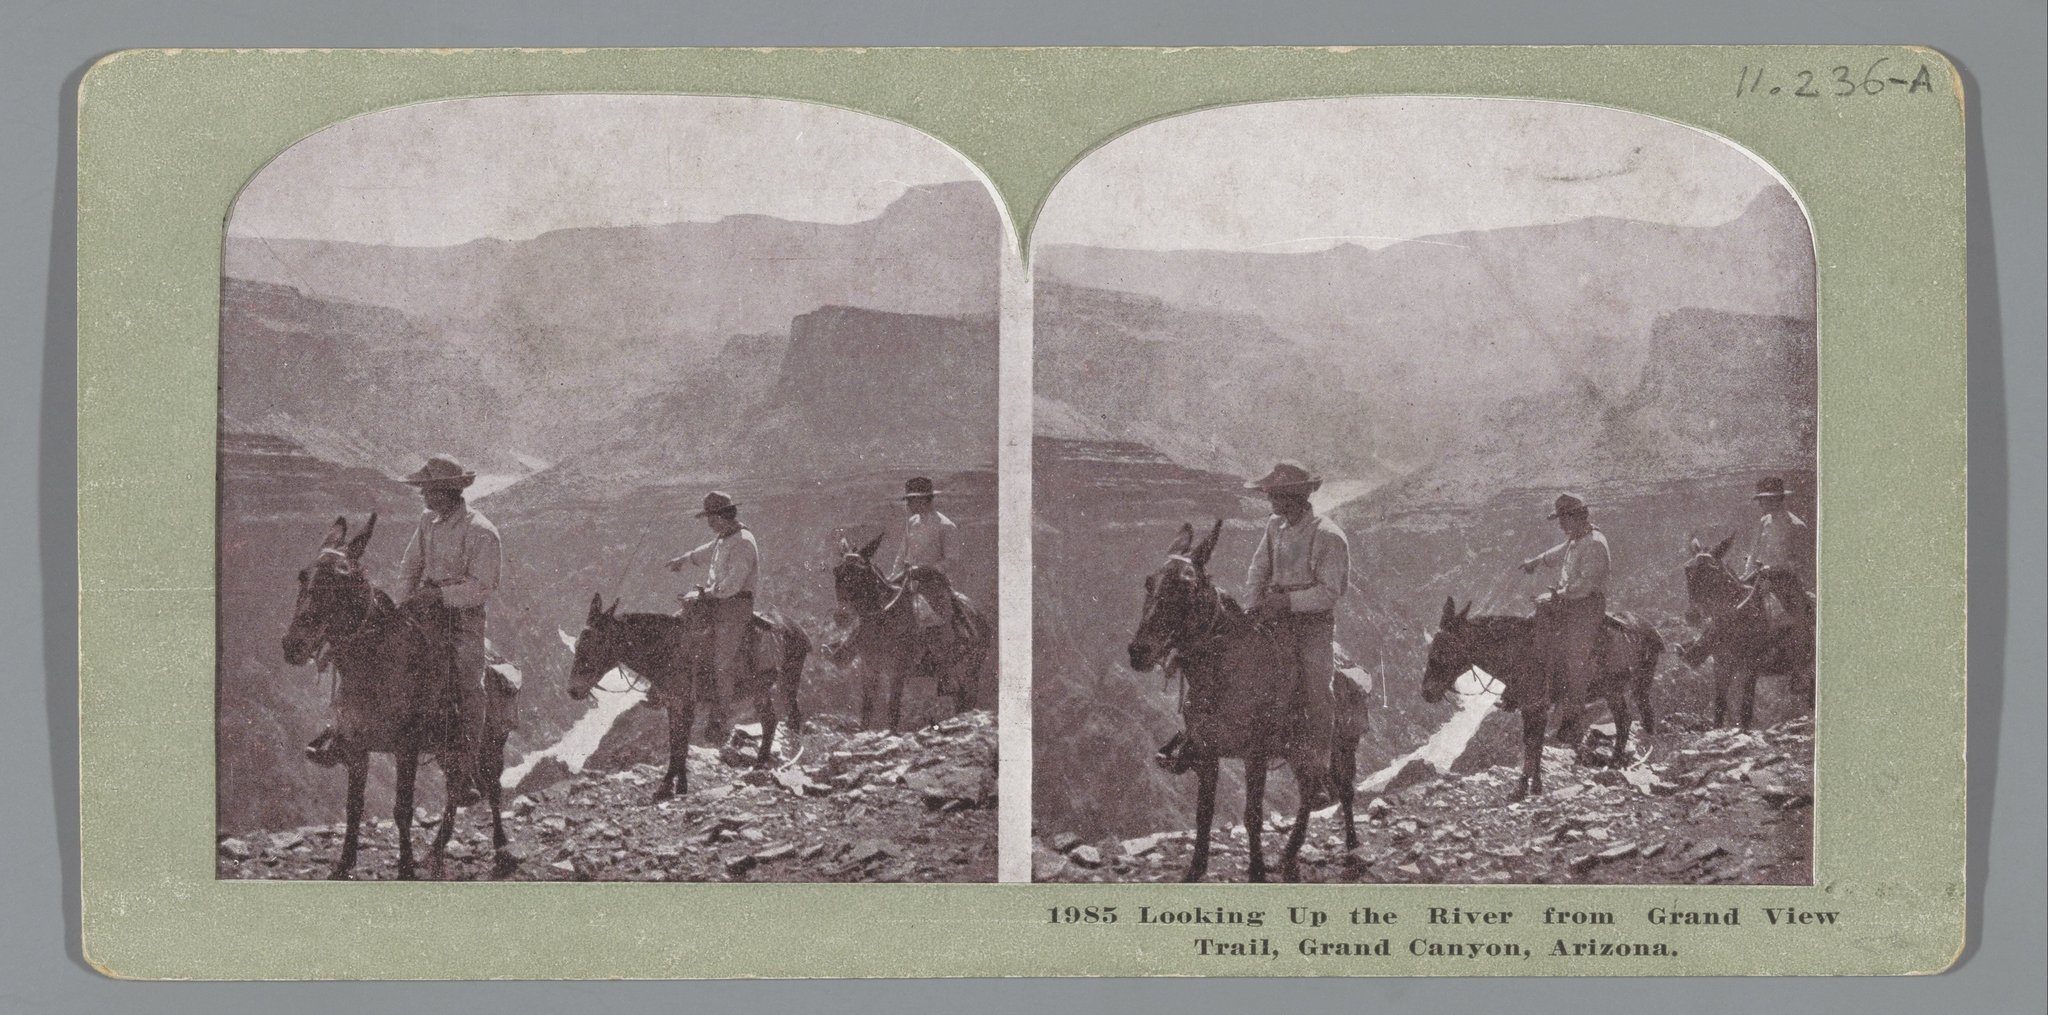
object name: stereograph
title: Ruiters te paard in Grandview Trail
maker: Anonymous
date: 1898-1930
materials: cardboard, photographic support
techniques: autotype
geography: grand canyon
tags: riding a horse, ass, or mule; rider, horseman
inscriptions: number: ‘1985’